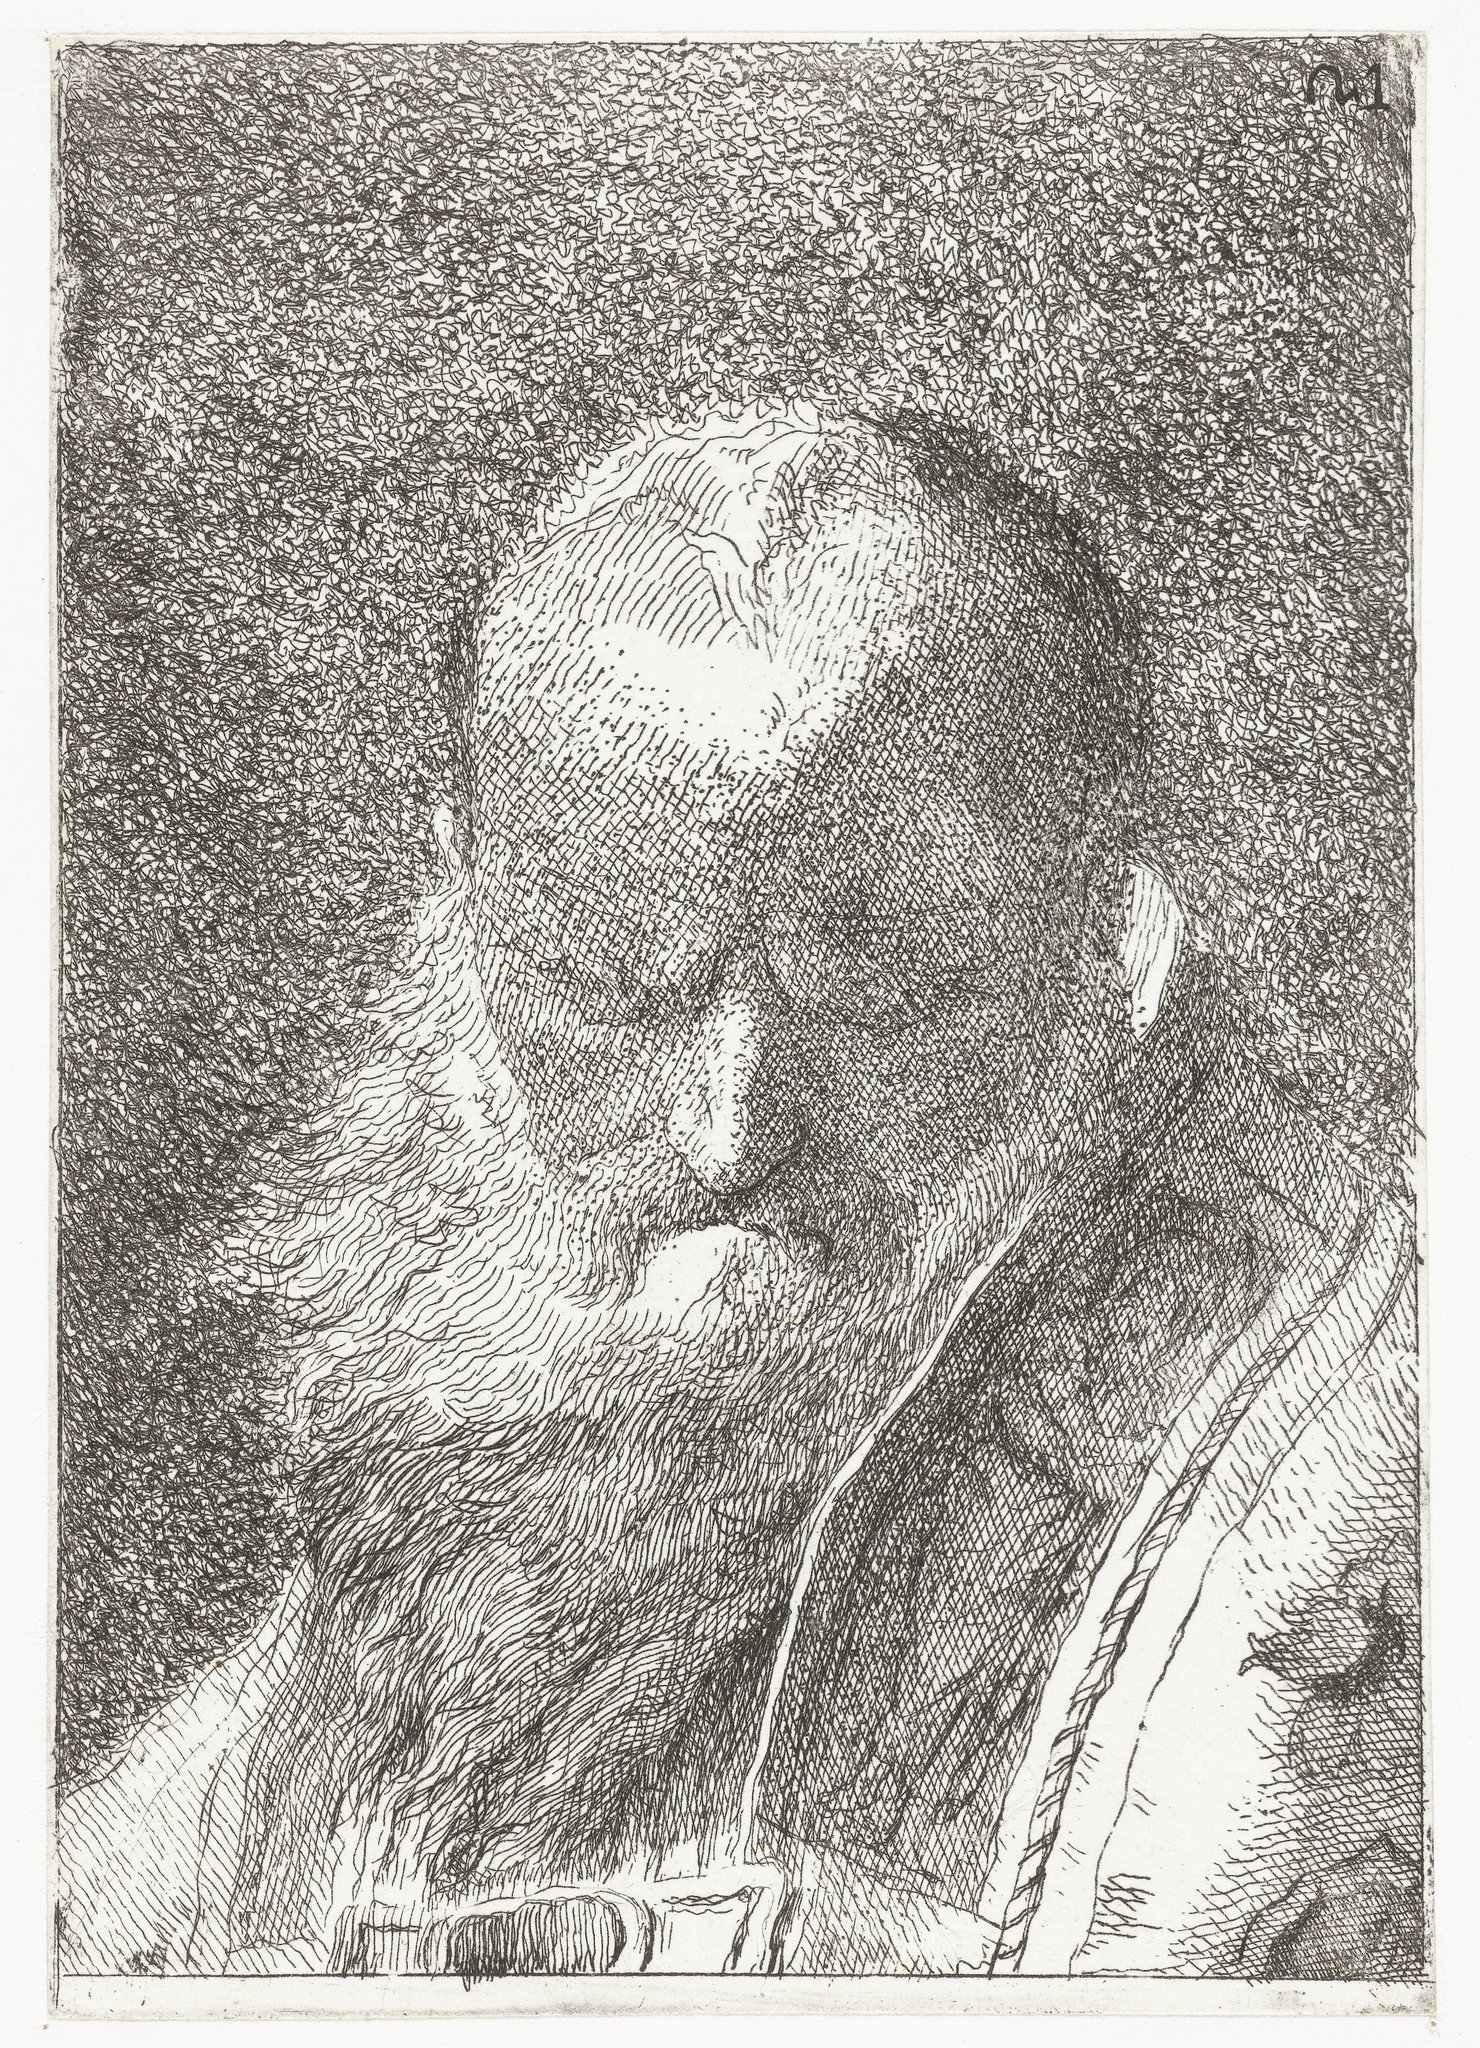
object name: print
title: Geestelijke met kaal hoofd in kazuifel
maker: giovanni domenico tiepolo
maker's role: draughtsman, print maker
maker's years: 1727-1804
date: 1757-1758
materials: paper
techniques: etching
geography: venice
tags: old man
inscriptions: collector's mark: Lugt 2228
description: Prent uit serie Verzameling hoofden (Raccolta di teste). Giovanni Domenico Tiepolo vervaardigde in de winter van 1757-1758 en in de periode van 1771-1774 deze hoofden naar schilderijen en tekeningen van Giovanni Battista Tiepolo. De eerste uitgave verscheen in 1774 in twee delen met elk dertig prenten. Deze prent werd opgenomen in deel 1.